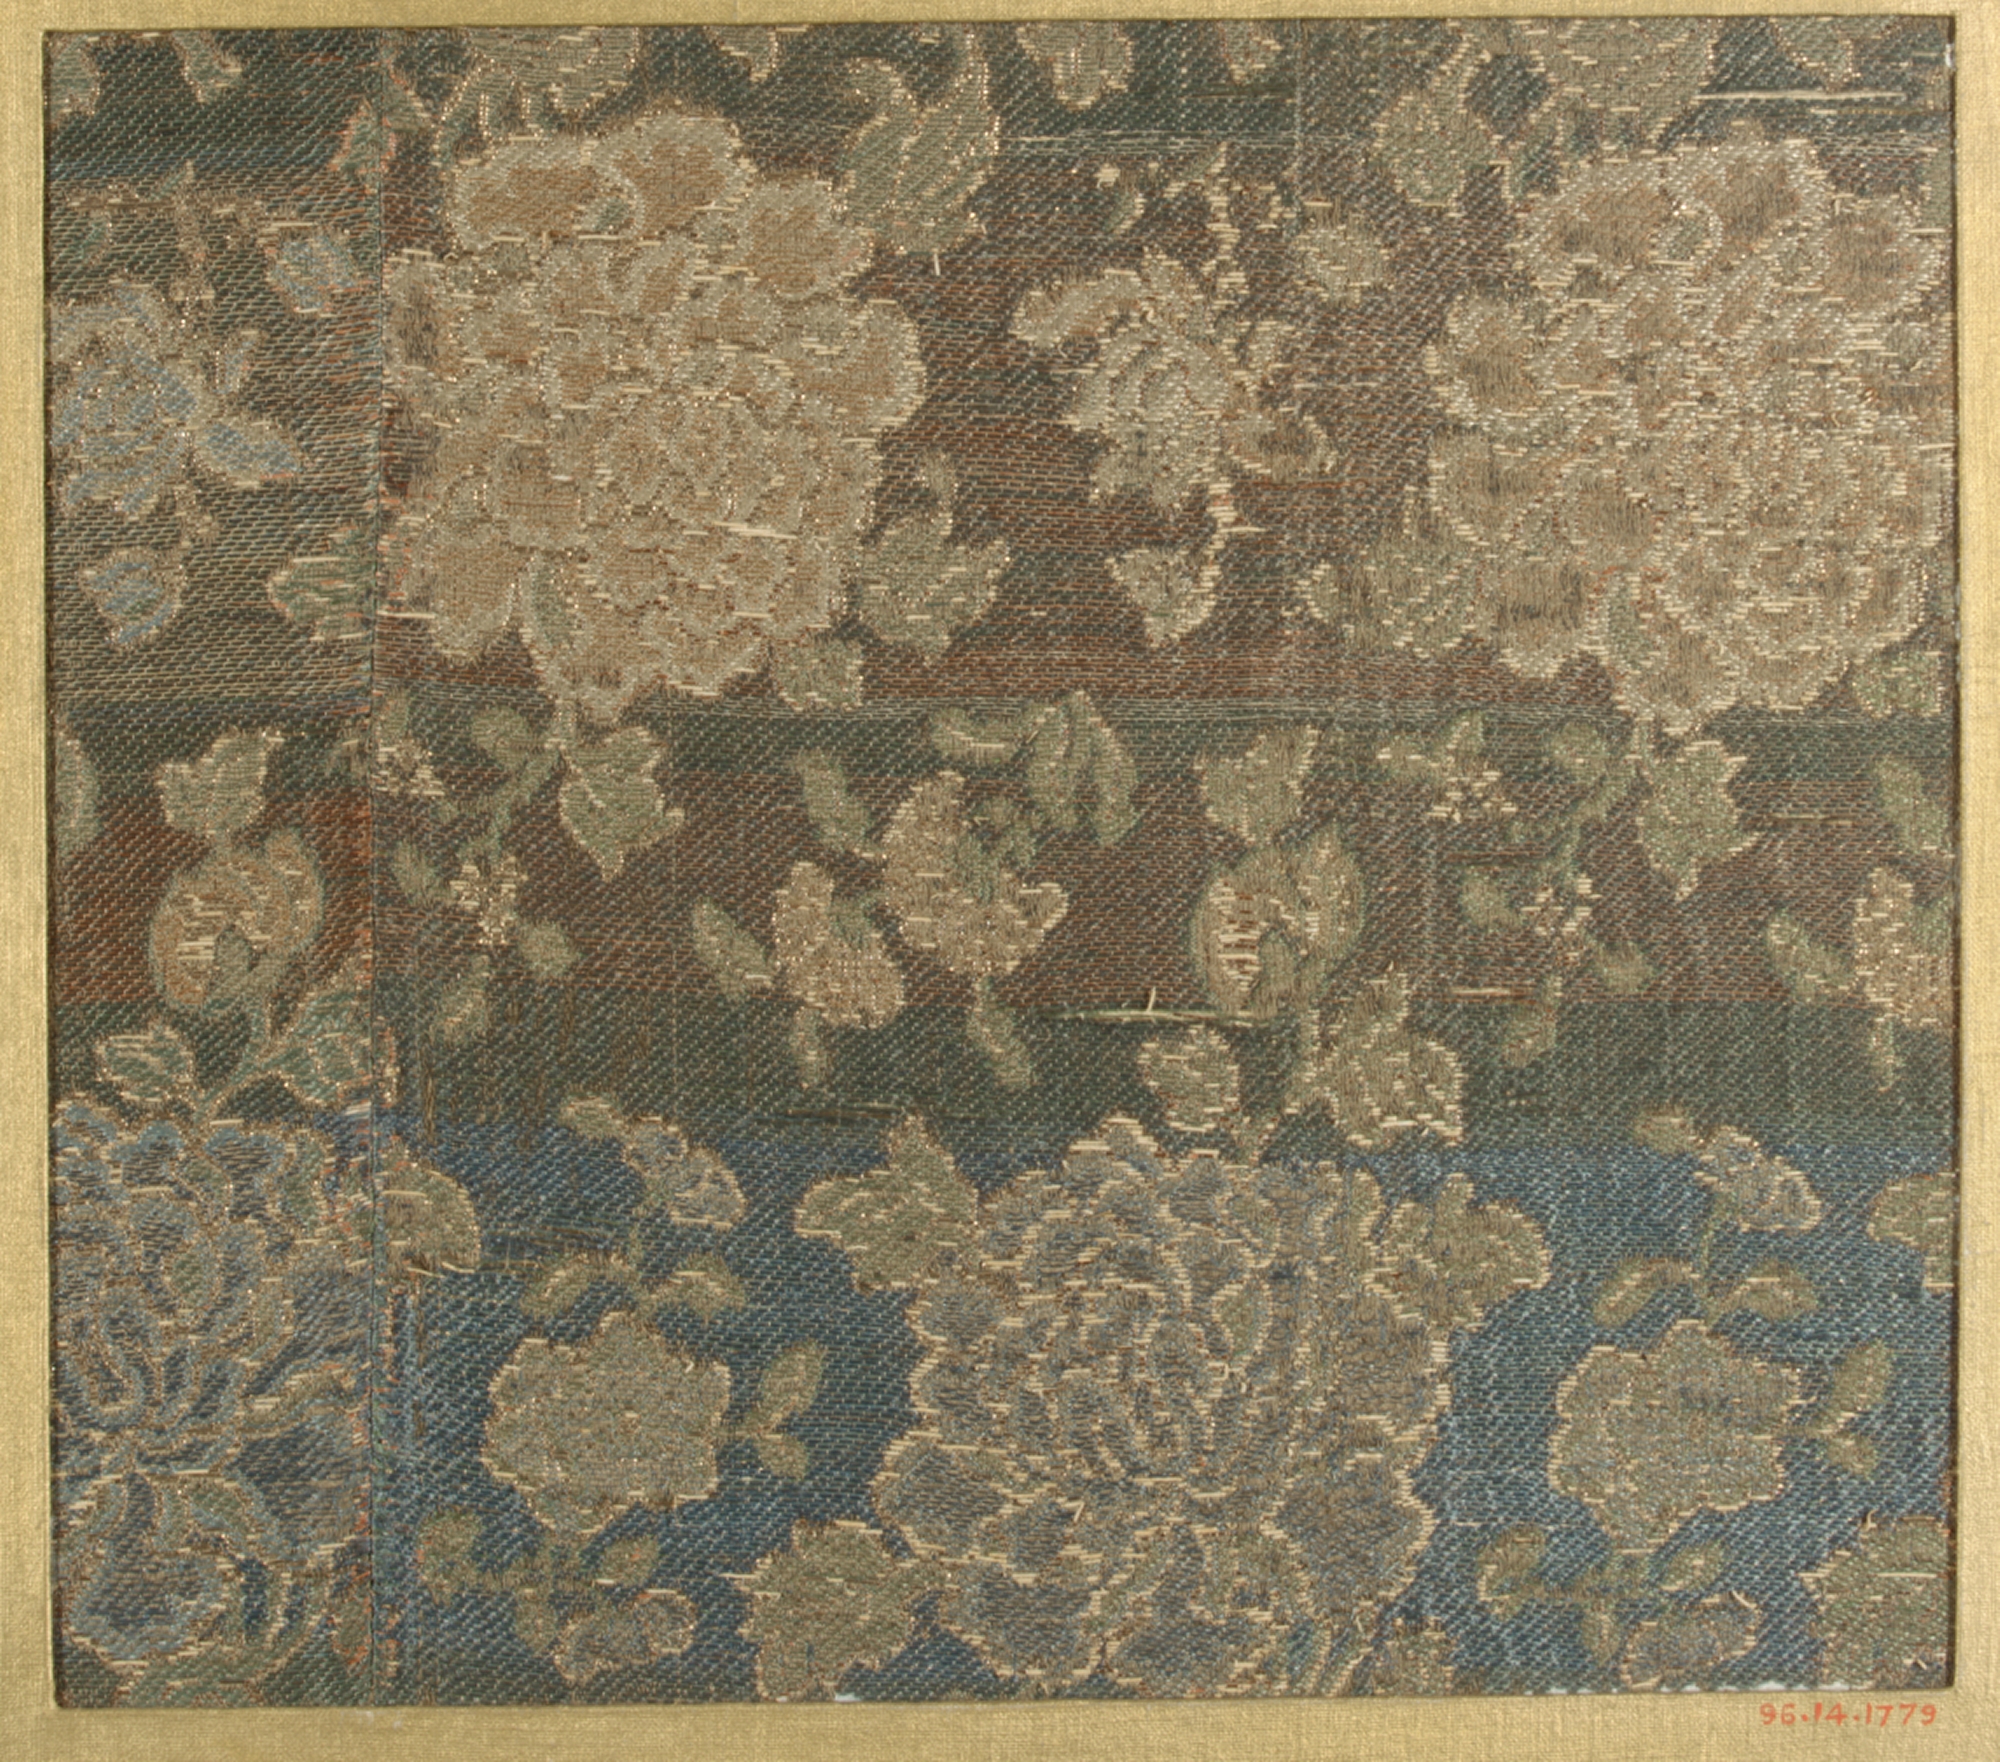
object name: piece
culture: japanese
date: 1701-1900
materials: silk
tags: flowers